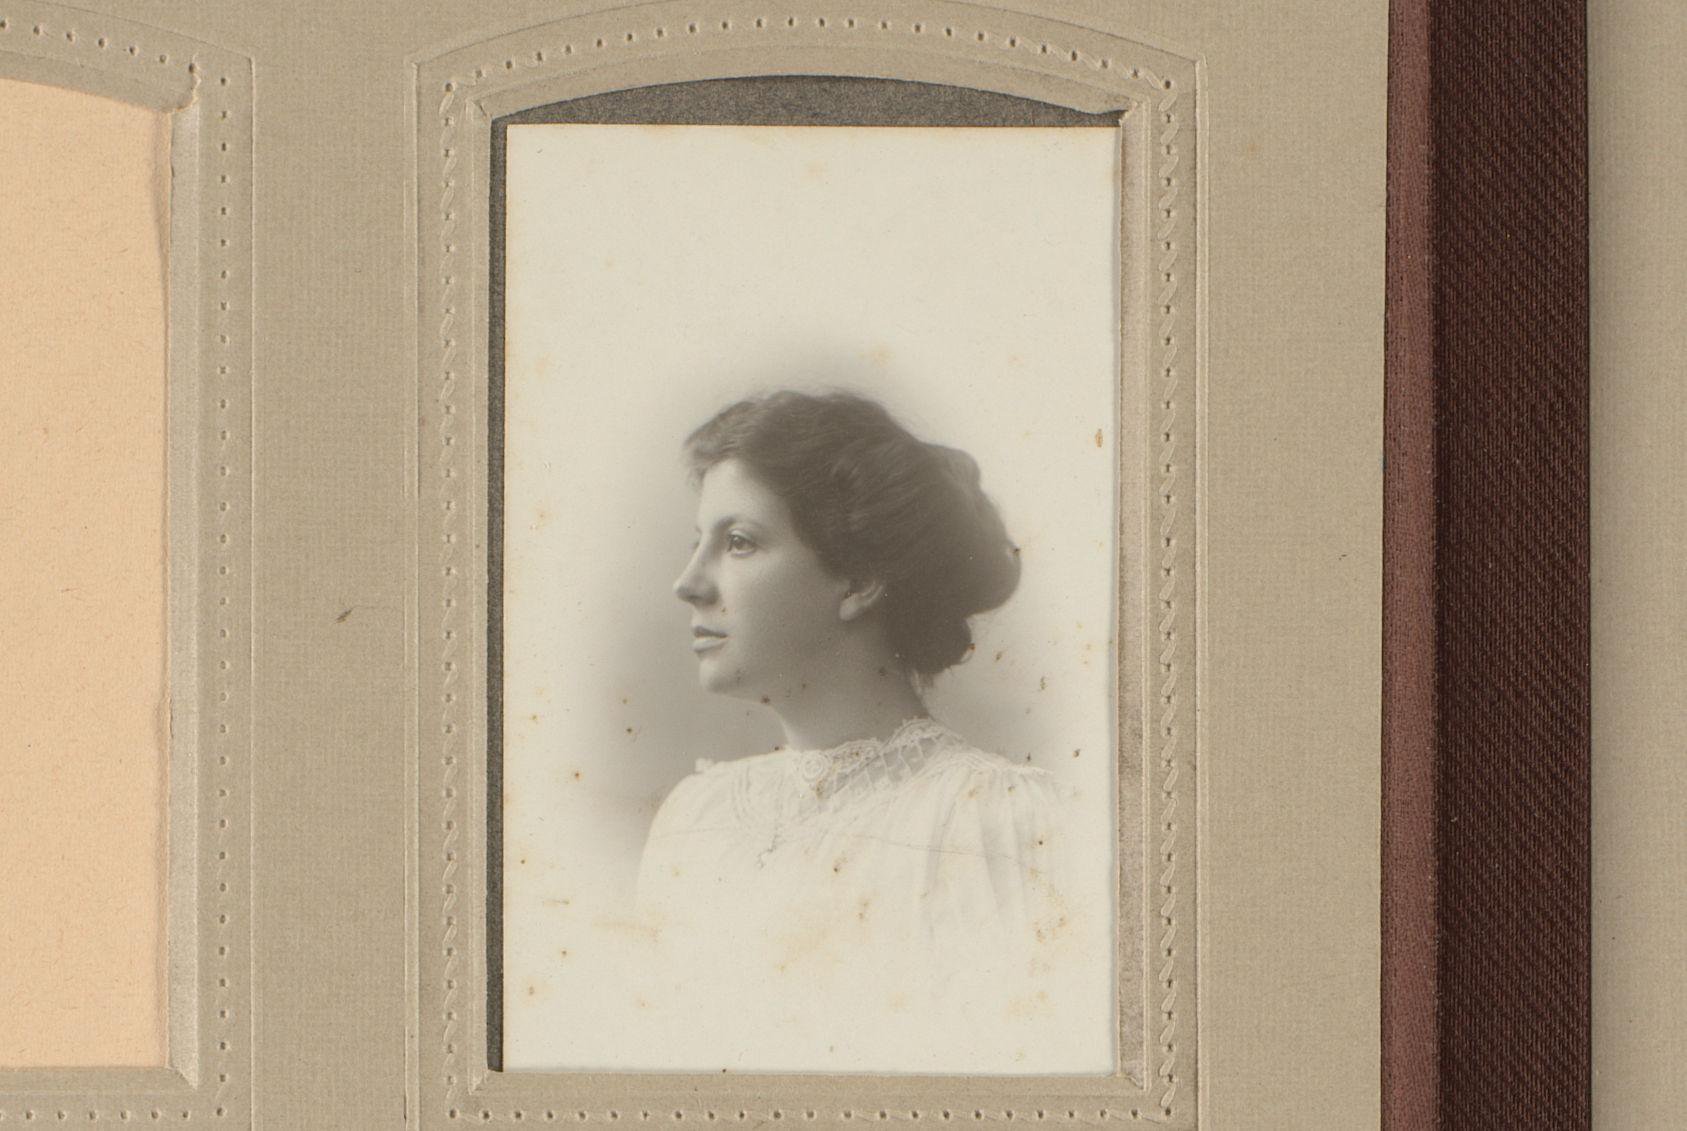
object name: photograph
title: Portret van een jonge vrouw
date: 1900-1910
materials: paper, photographic support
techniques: gelatin silver print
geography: netherlands